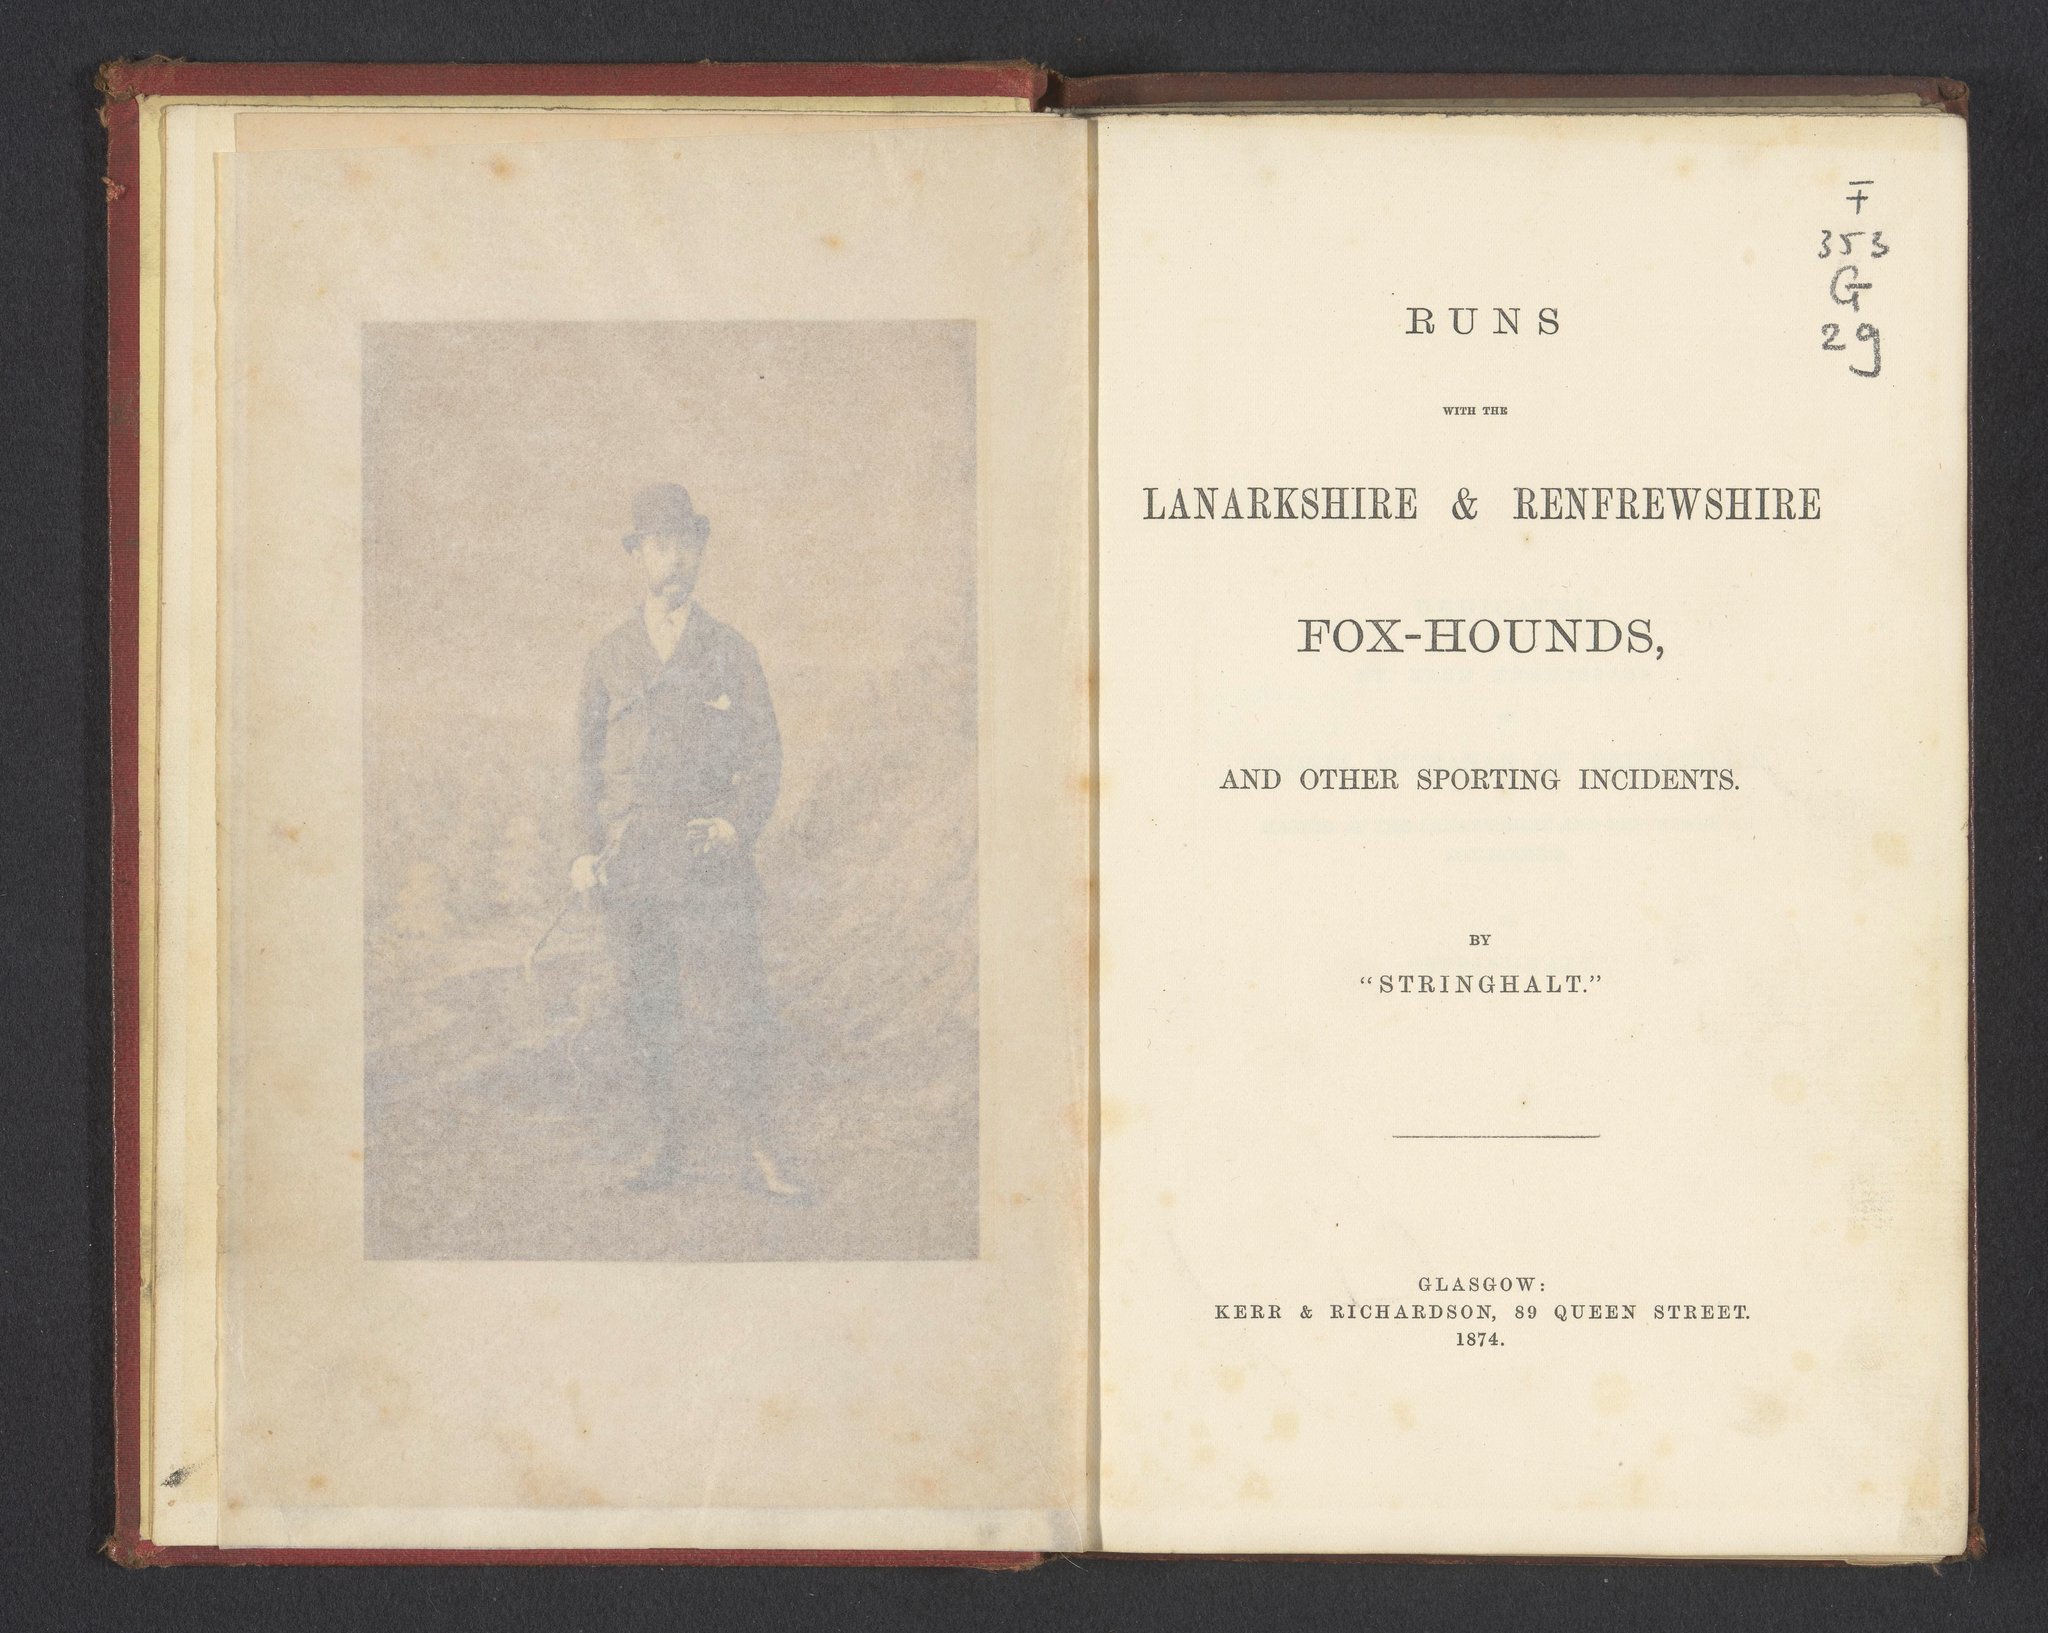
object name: book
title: Runs with the lanarkshire and renfrewshire fox-hounds, and other sporting incidents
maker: stringhalt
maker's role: schrijver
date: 1874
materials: linen, paper, photographic support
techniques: albumen print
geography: glasgow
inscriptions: name: ‘Thomas F. Perman’, name: ‘ex libris SFJ’